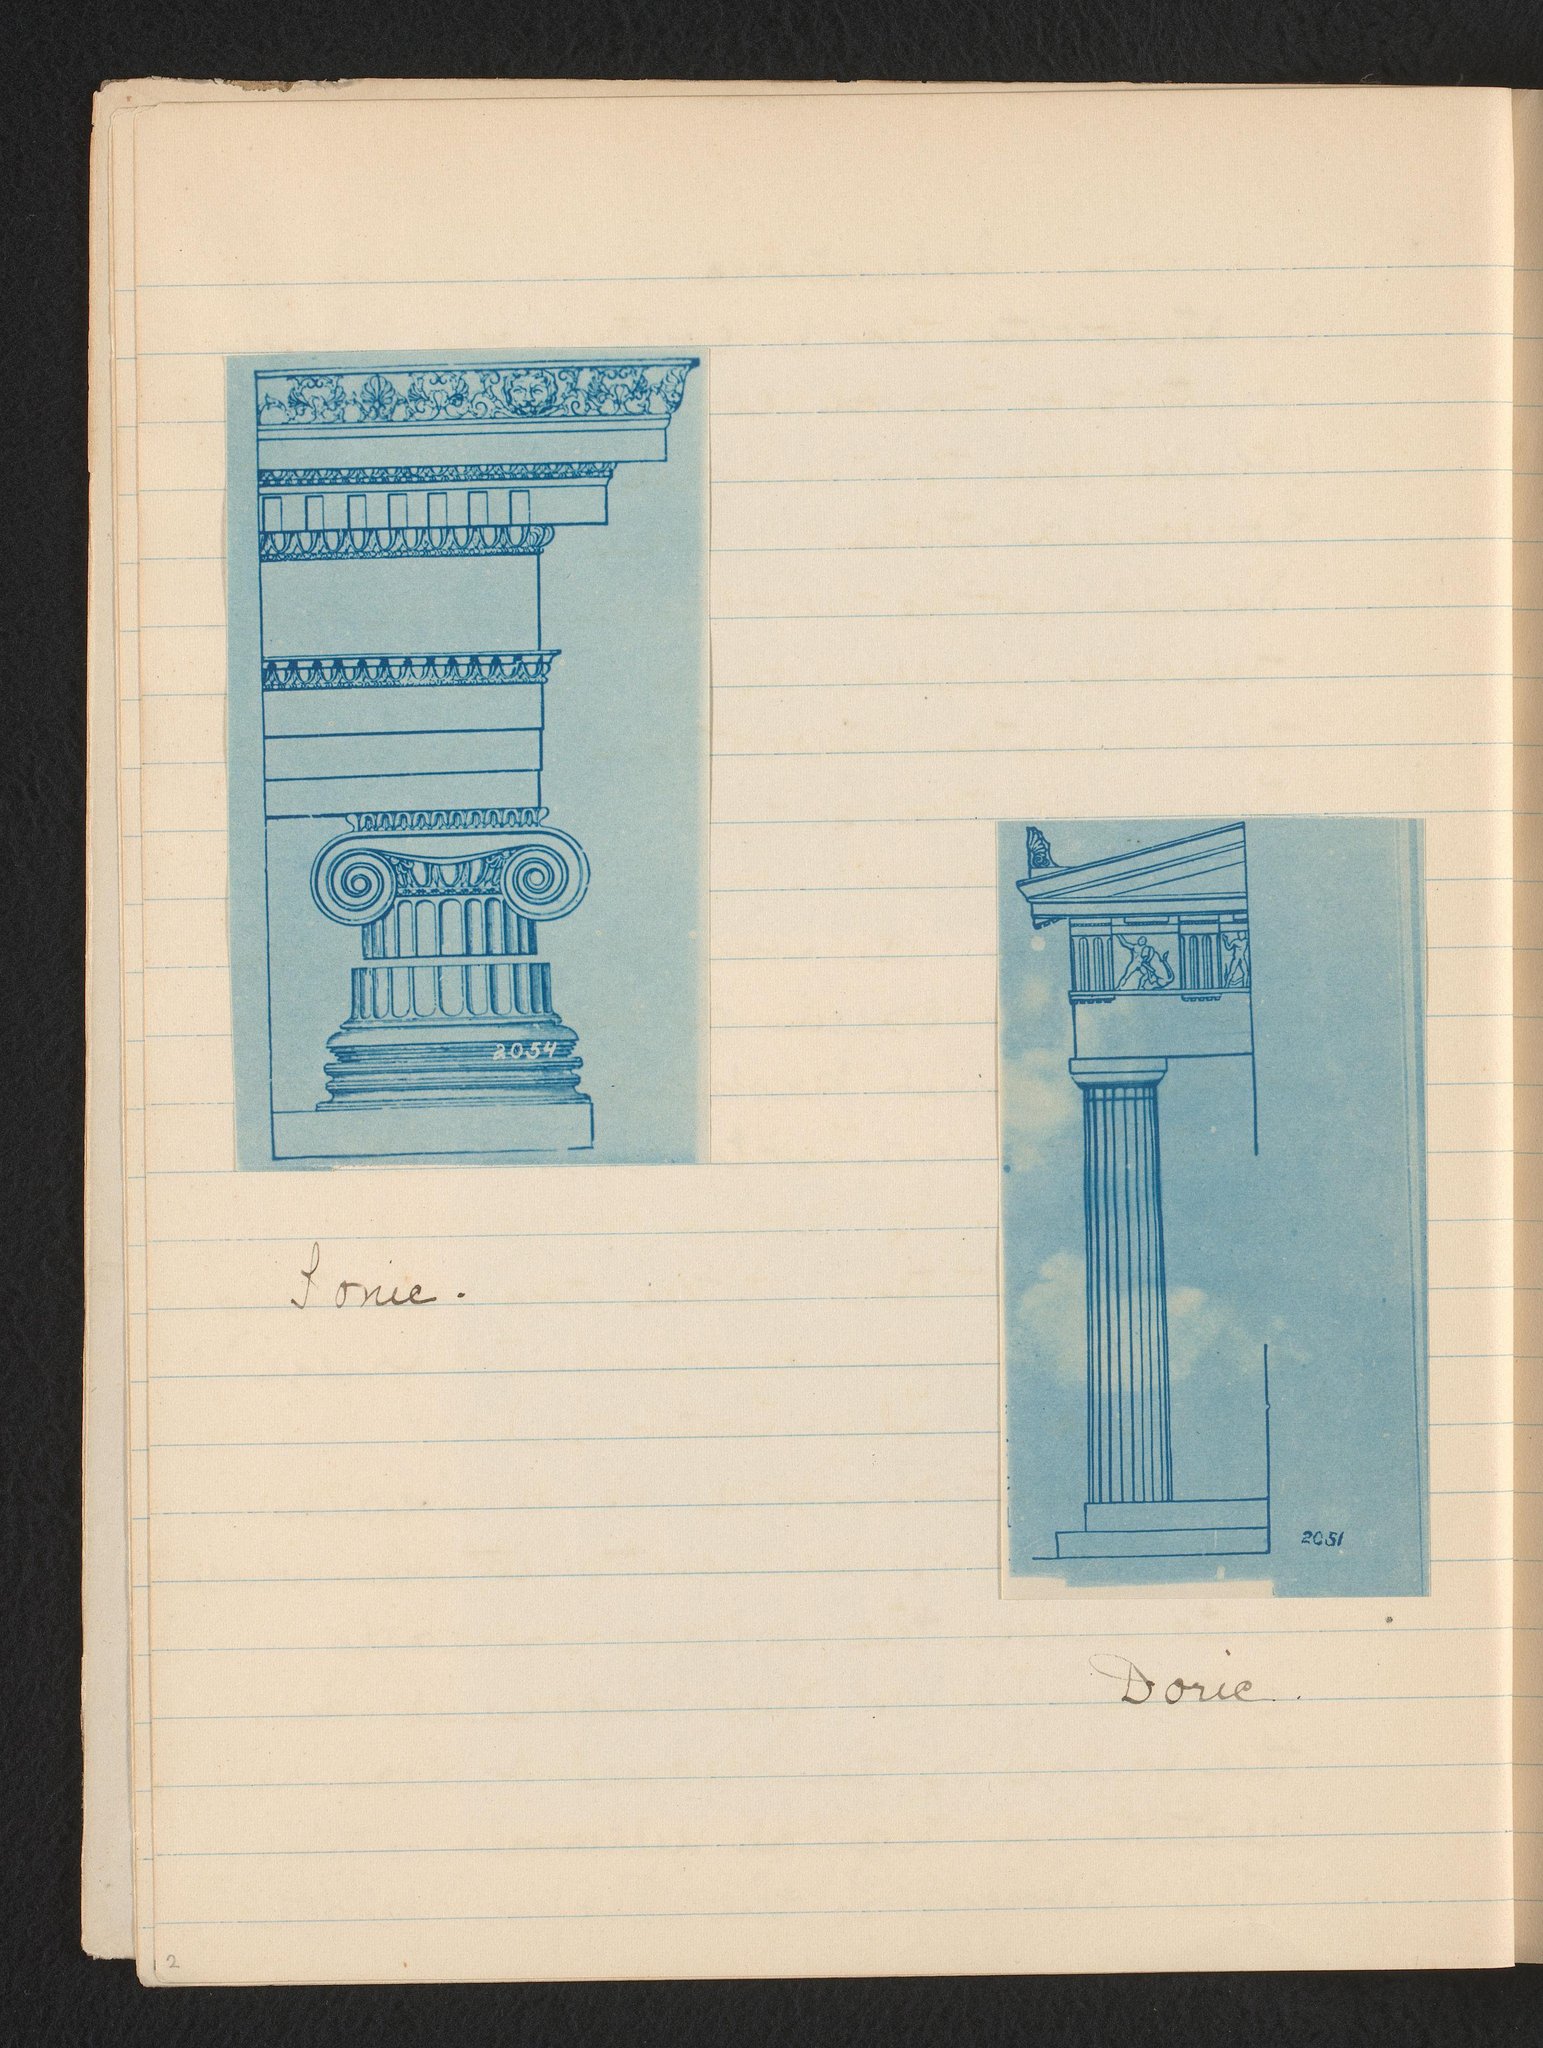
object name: photograph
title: Twee fotoreproducties van prenten van Griekse zuilen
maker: Anonymous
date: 1901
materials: paper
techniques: cyanotype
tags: doric order ~ architecture, ionic order ~ architecture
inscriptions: inscription: ‘Ionic/ Doric’, number: ‘2054/ 2051’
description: Deze foto's maken deel uit van een album.